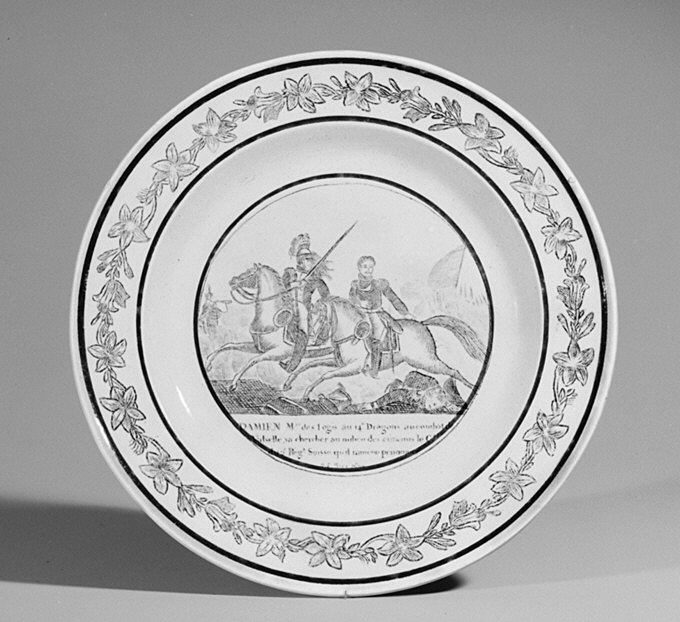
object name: plate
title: Plate (one of a set of five)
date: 1801-1900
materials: earthenware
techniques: glazing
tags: men,horses,flowers